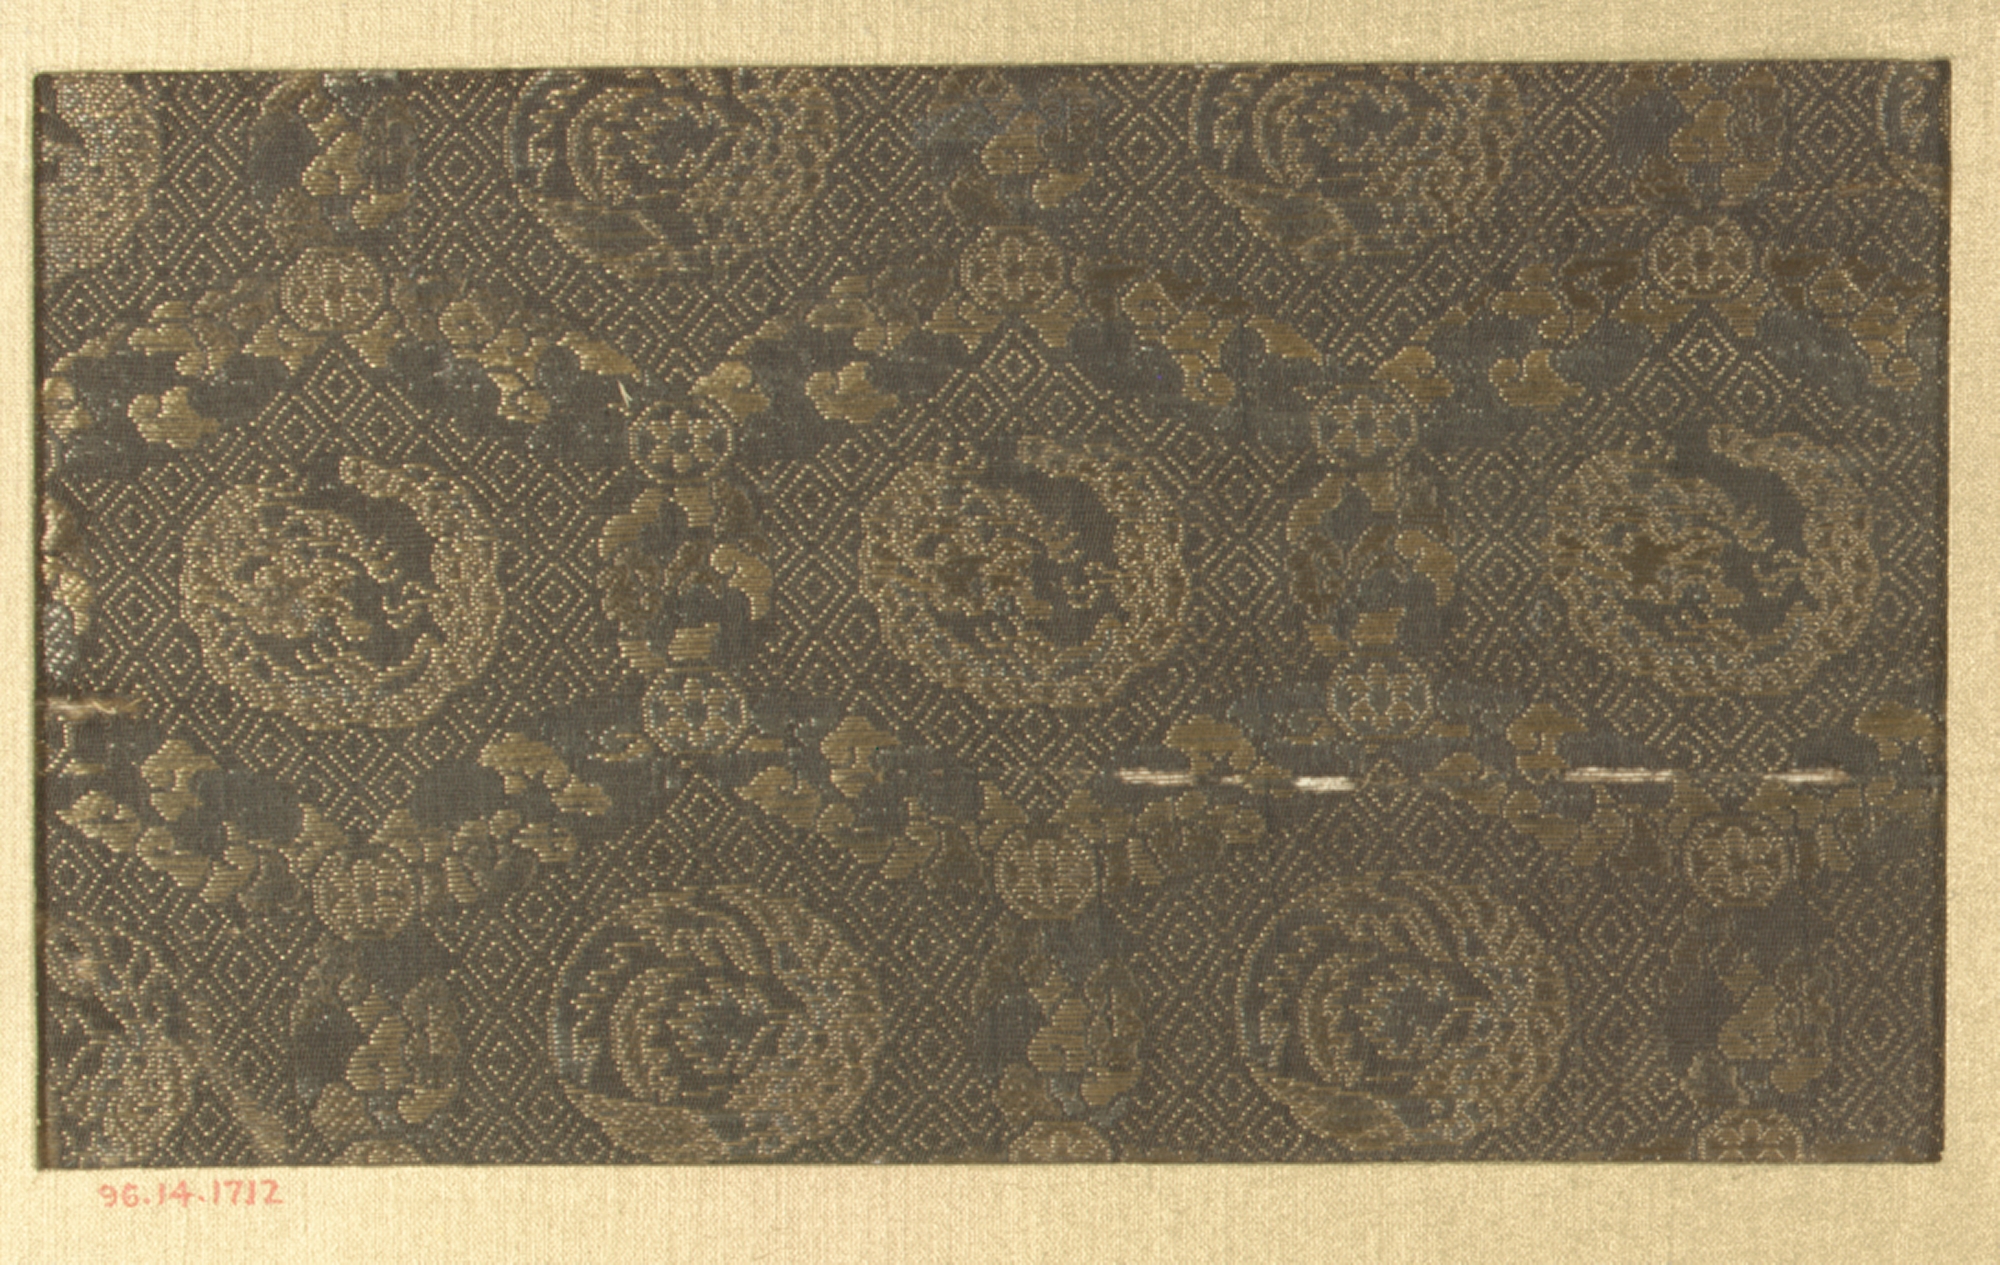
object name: piece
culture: japanese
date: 1701-1900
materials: silk